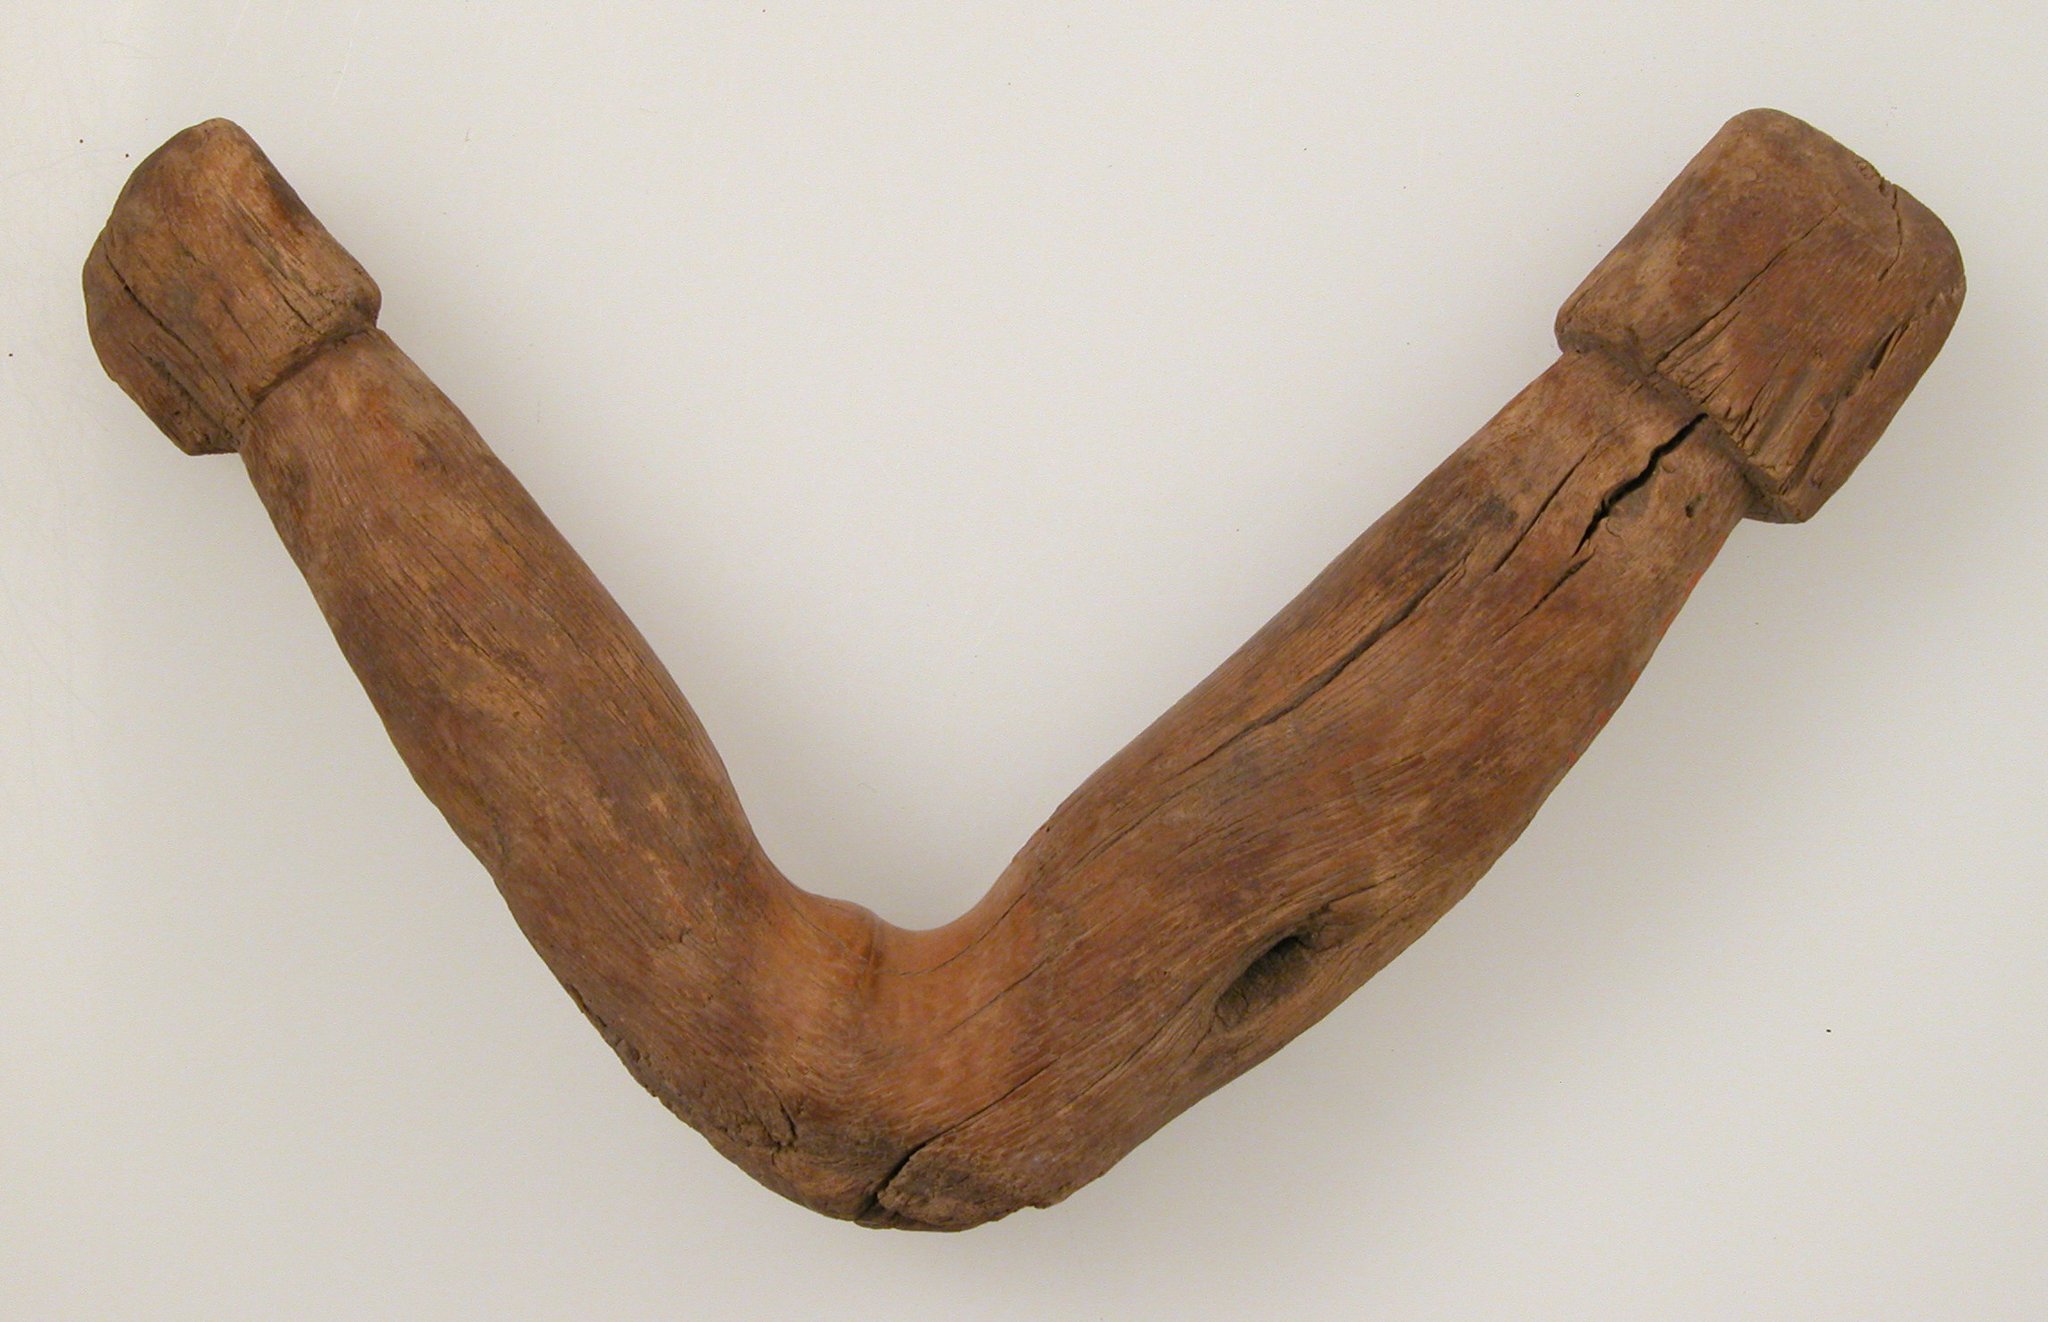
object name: pulley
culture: coptic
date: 580-640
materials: wood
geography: egypt